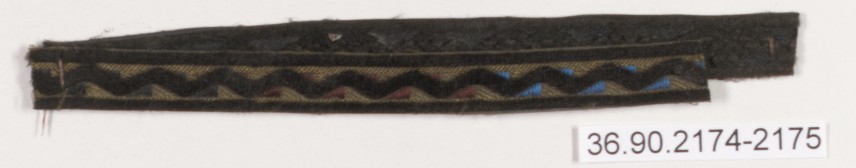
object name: piece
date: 1801-1900